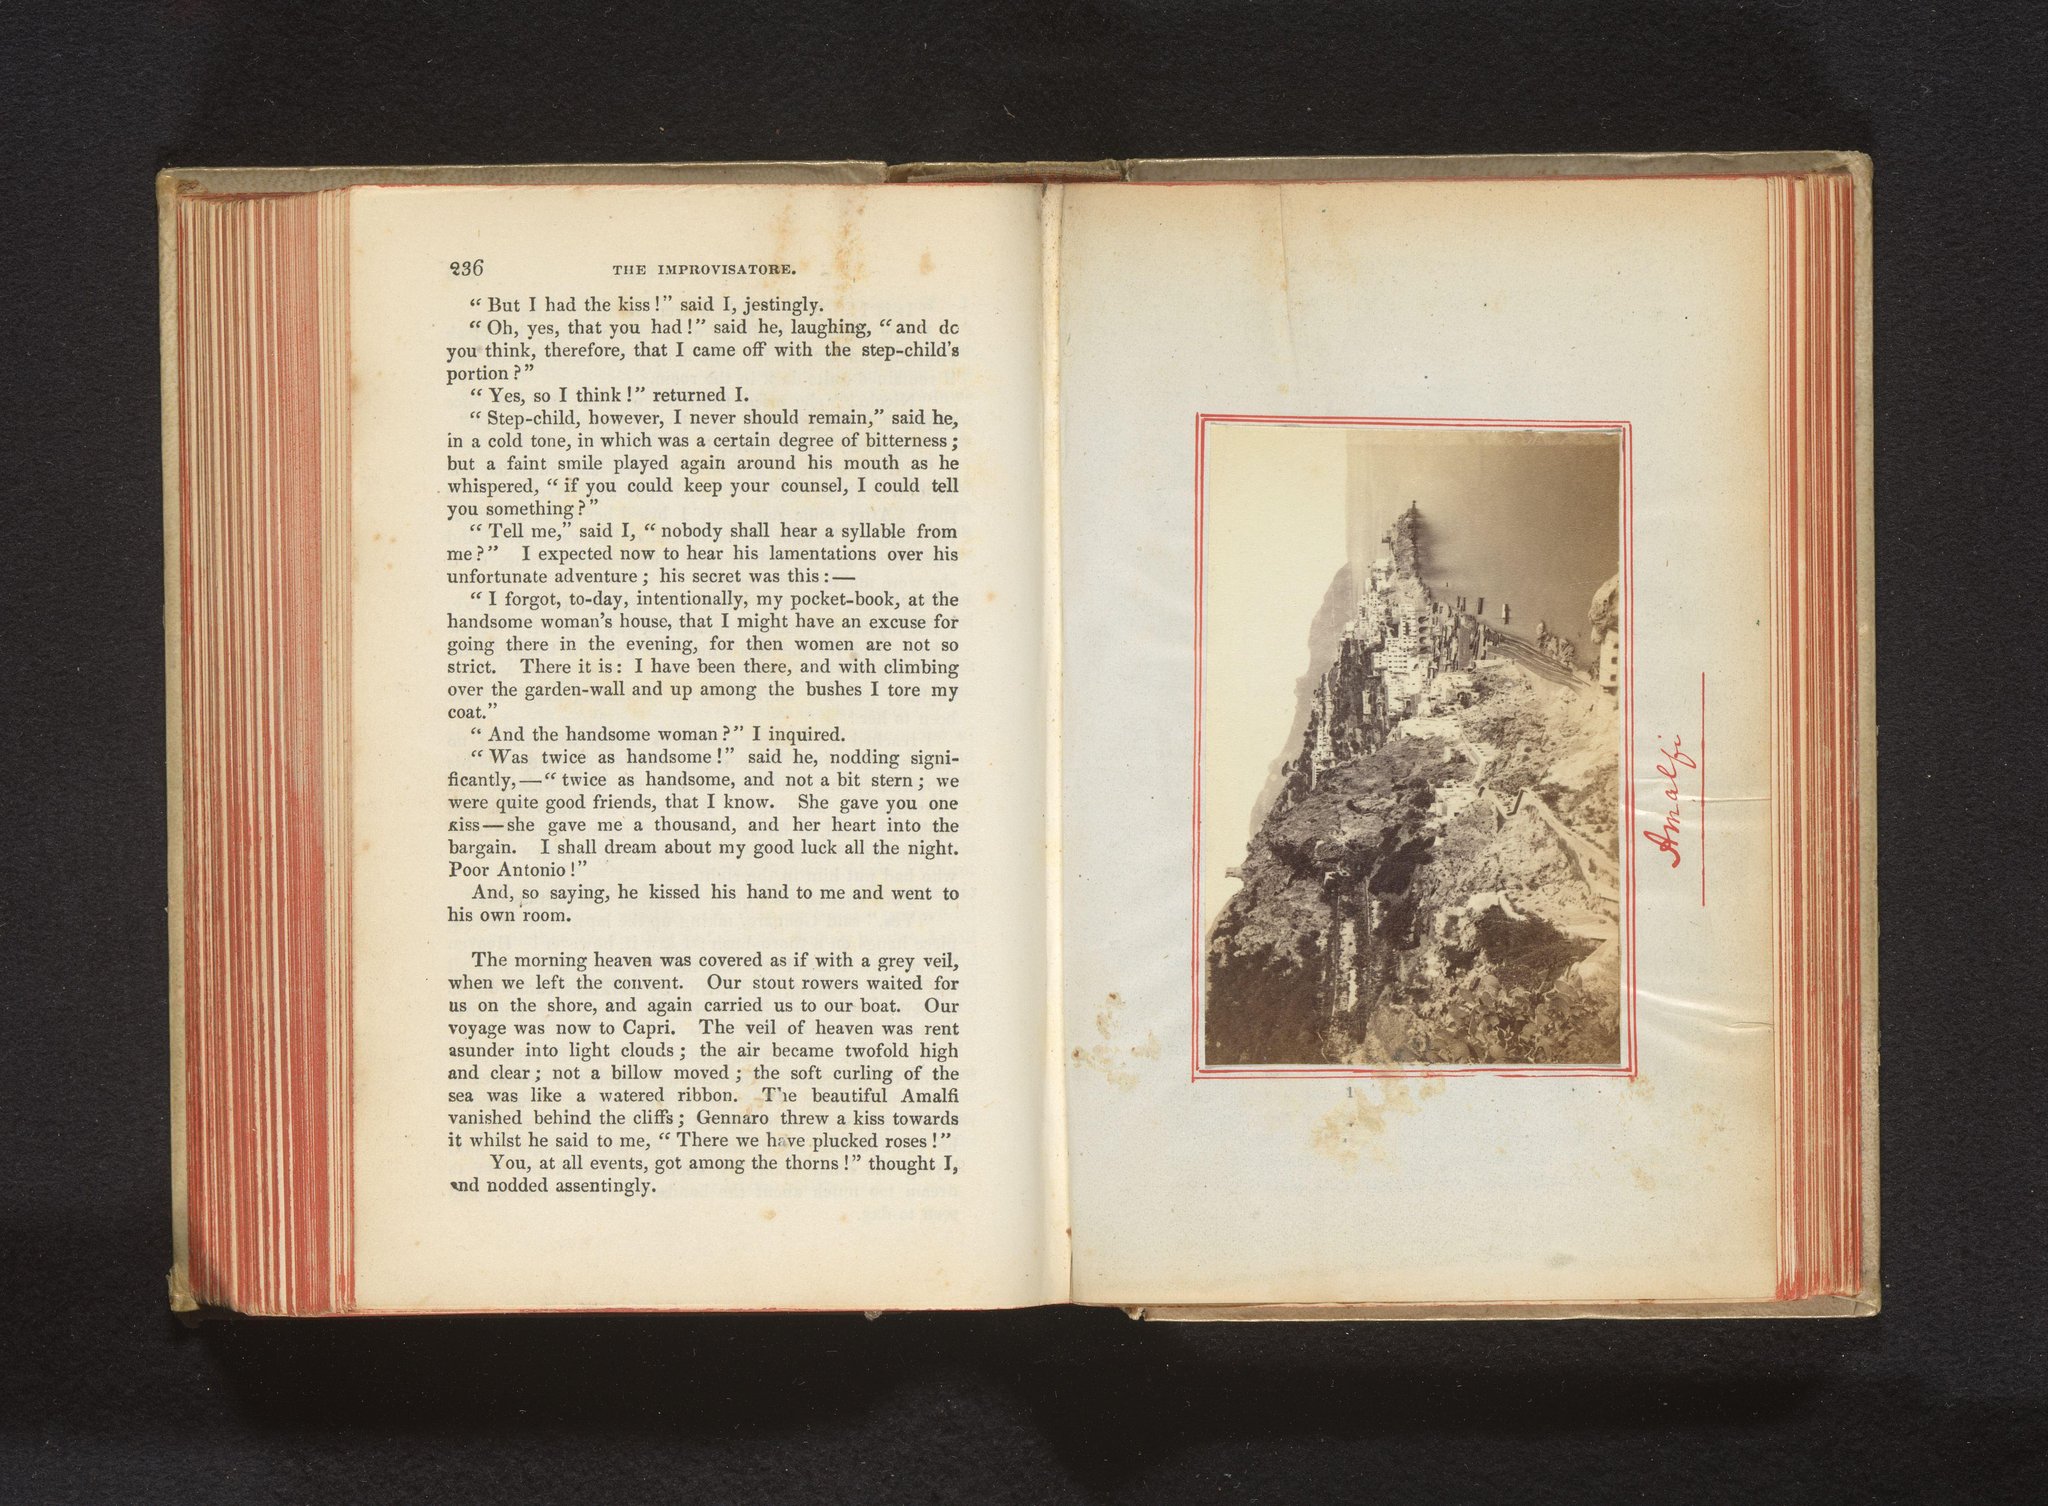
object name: page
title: Amalfi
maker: Anonymous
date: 1863-1873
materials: photographic support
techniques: albumen print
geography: amalfi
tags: city-view in general; 'veduta', rocky coast